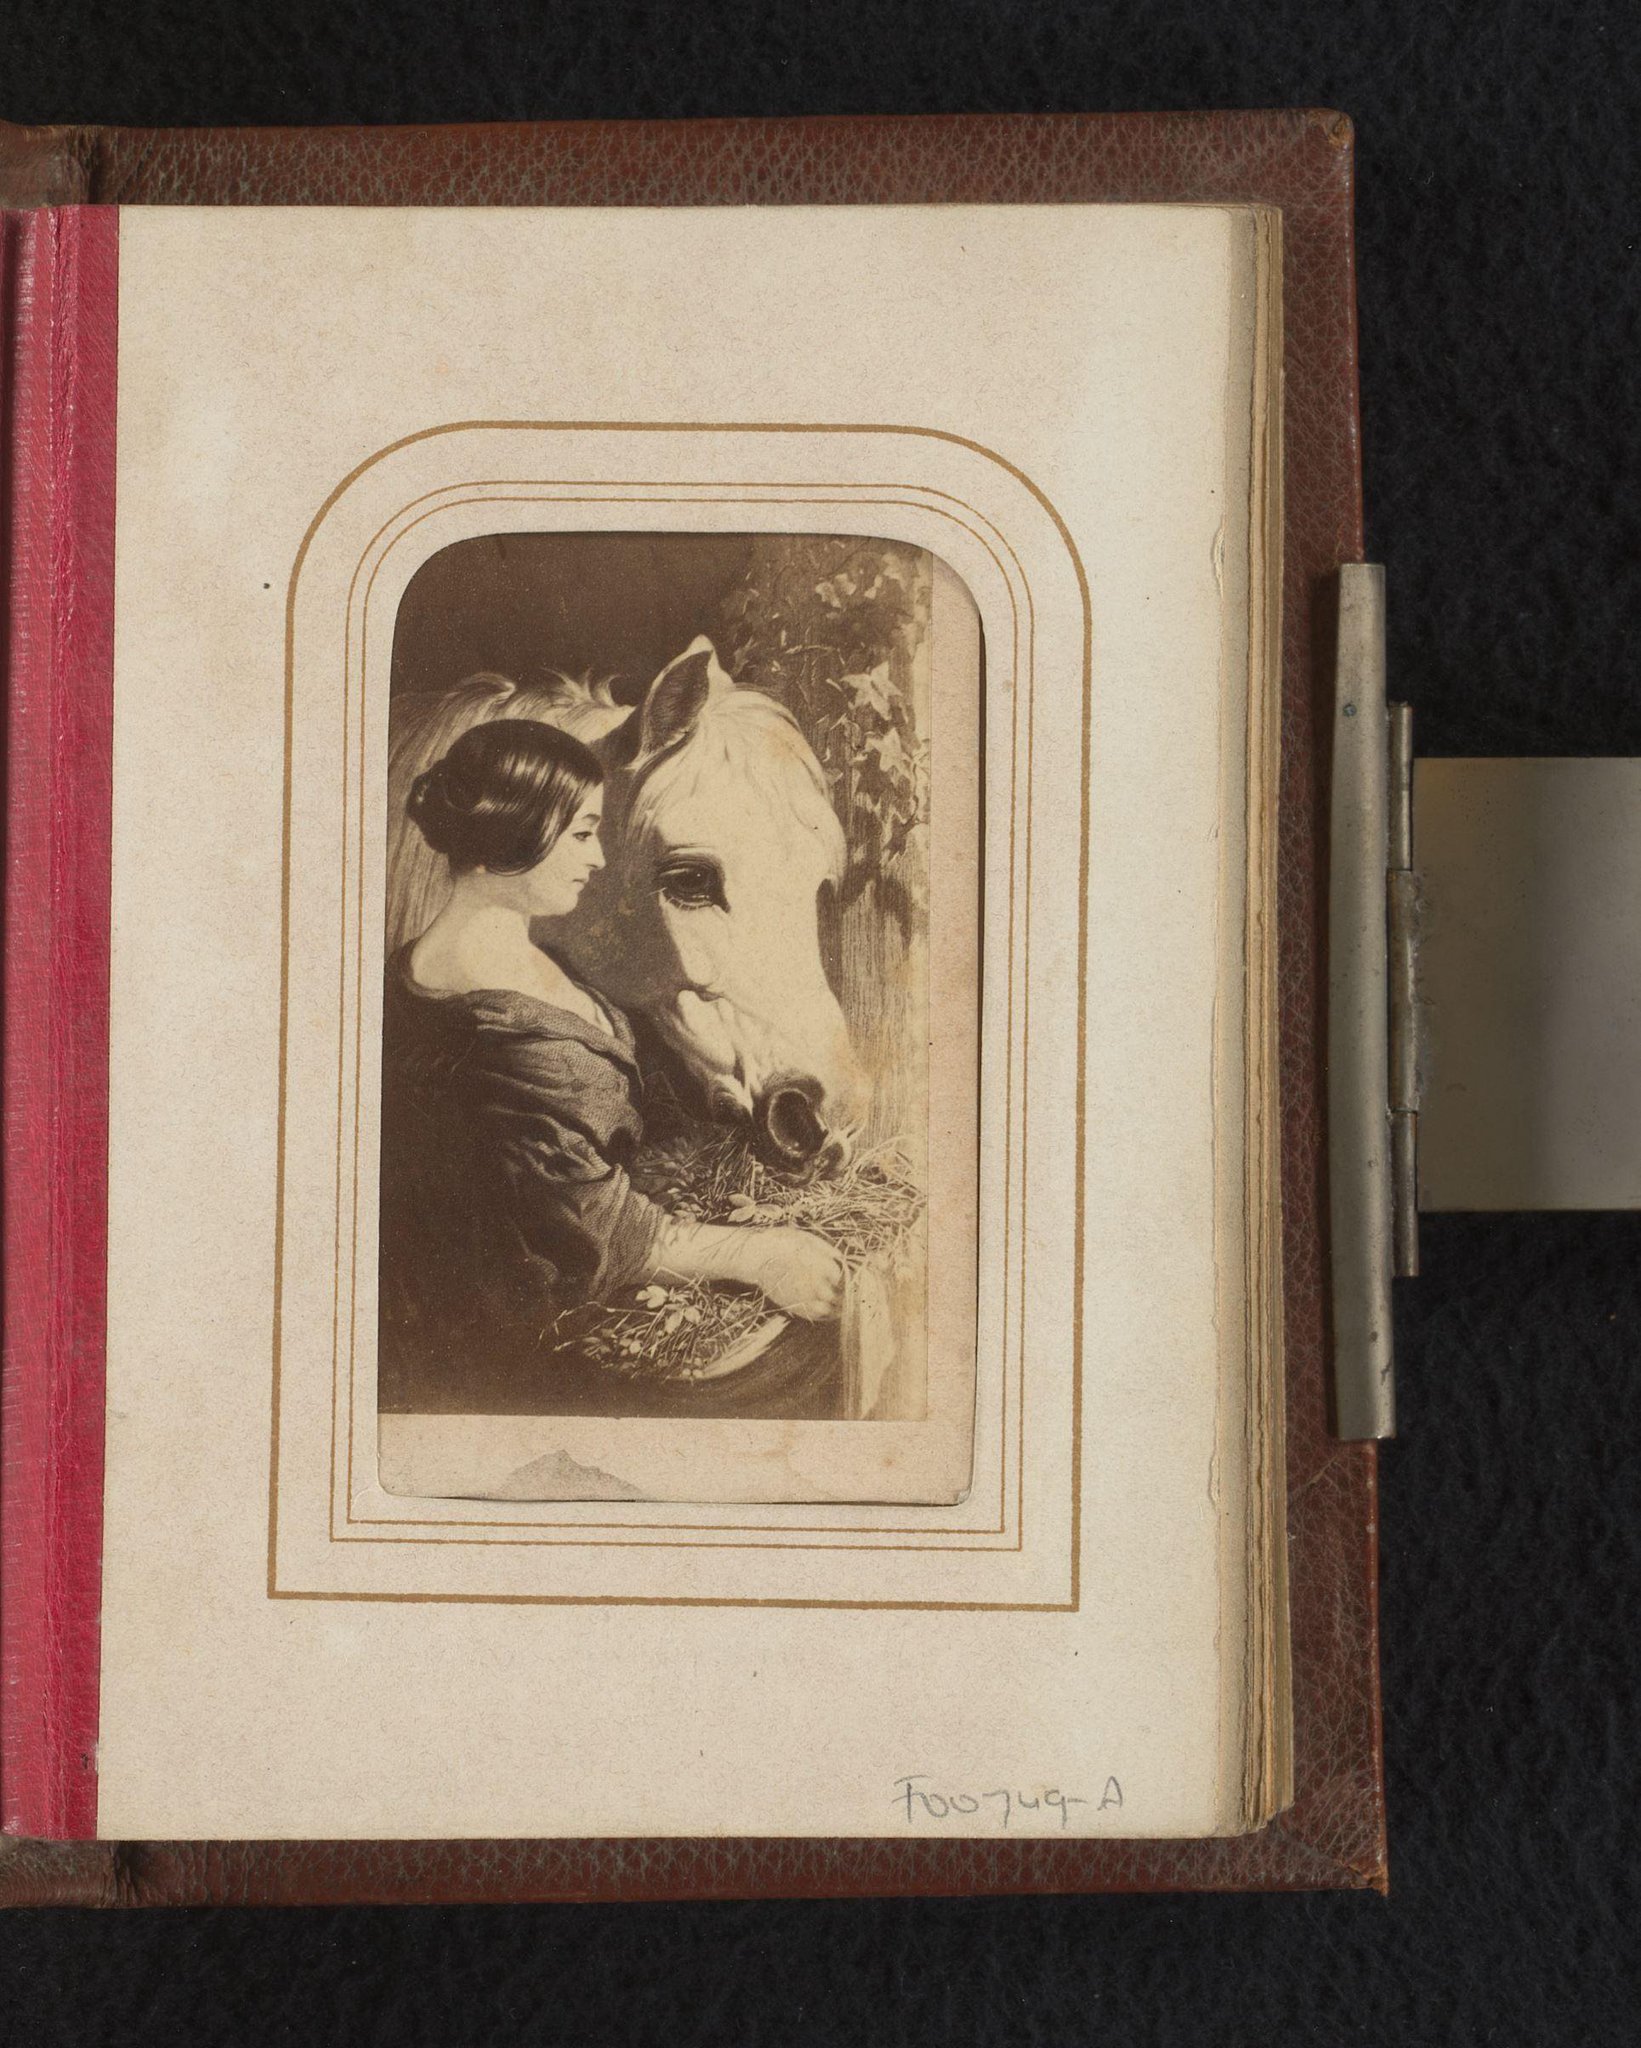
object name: carte de visite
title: Fotoreproductie van een schilderij met een vrouw die een paard voedt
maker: Anonymous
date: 1865-1900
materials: cardboard, photographic support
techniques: albumen print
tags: historical persons - bb - woman, horse